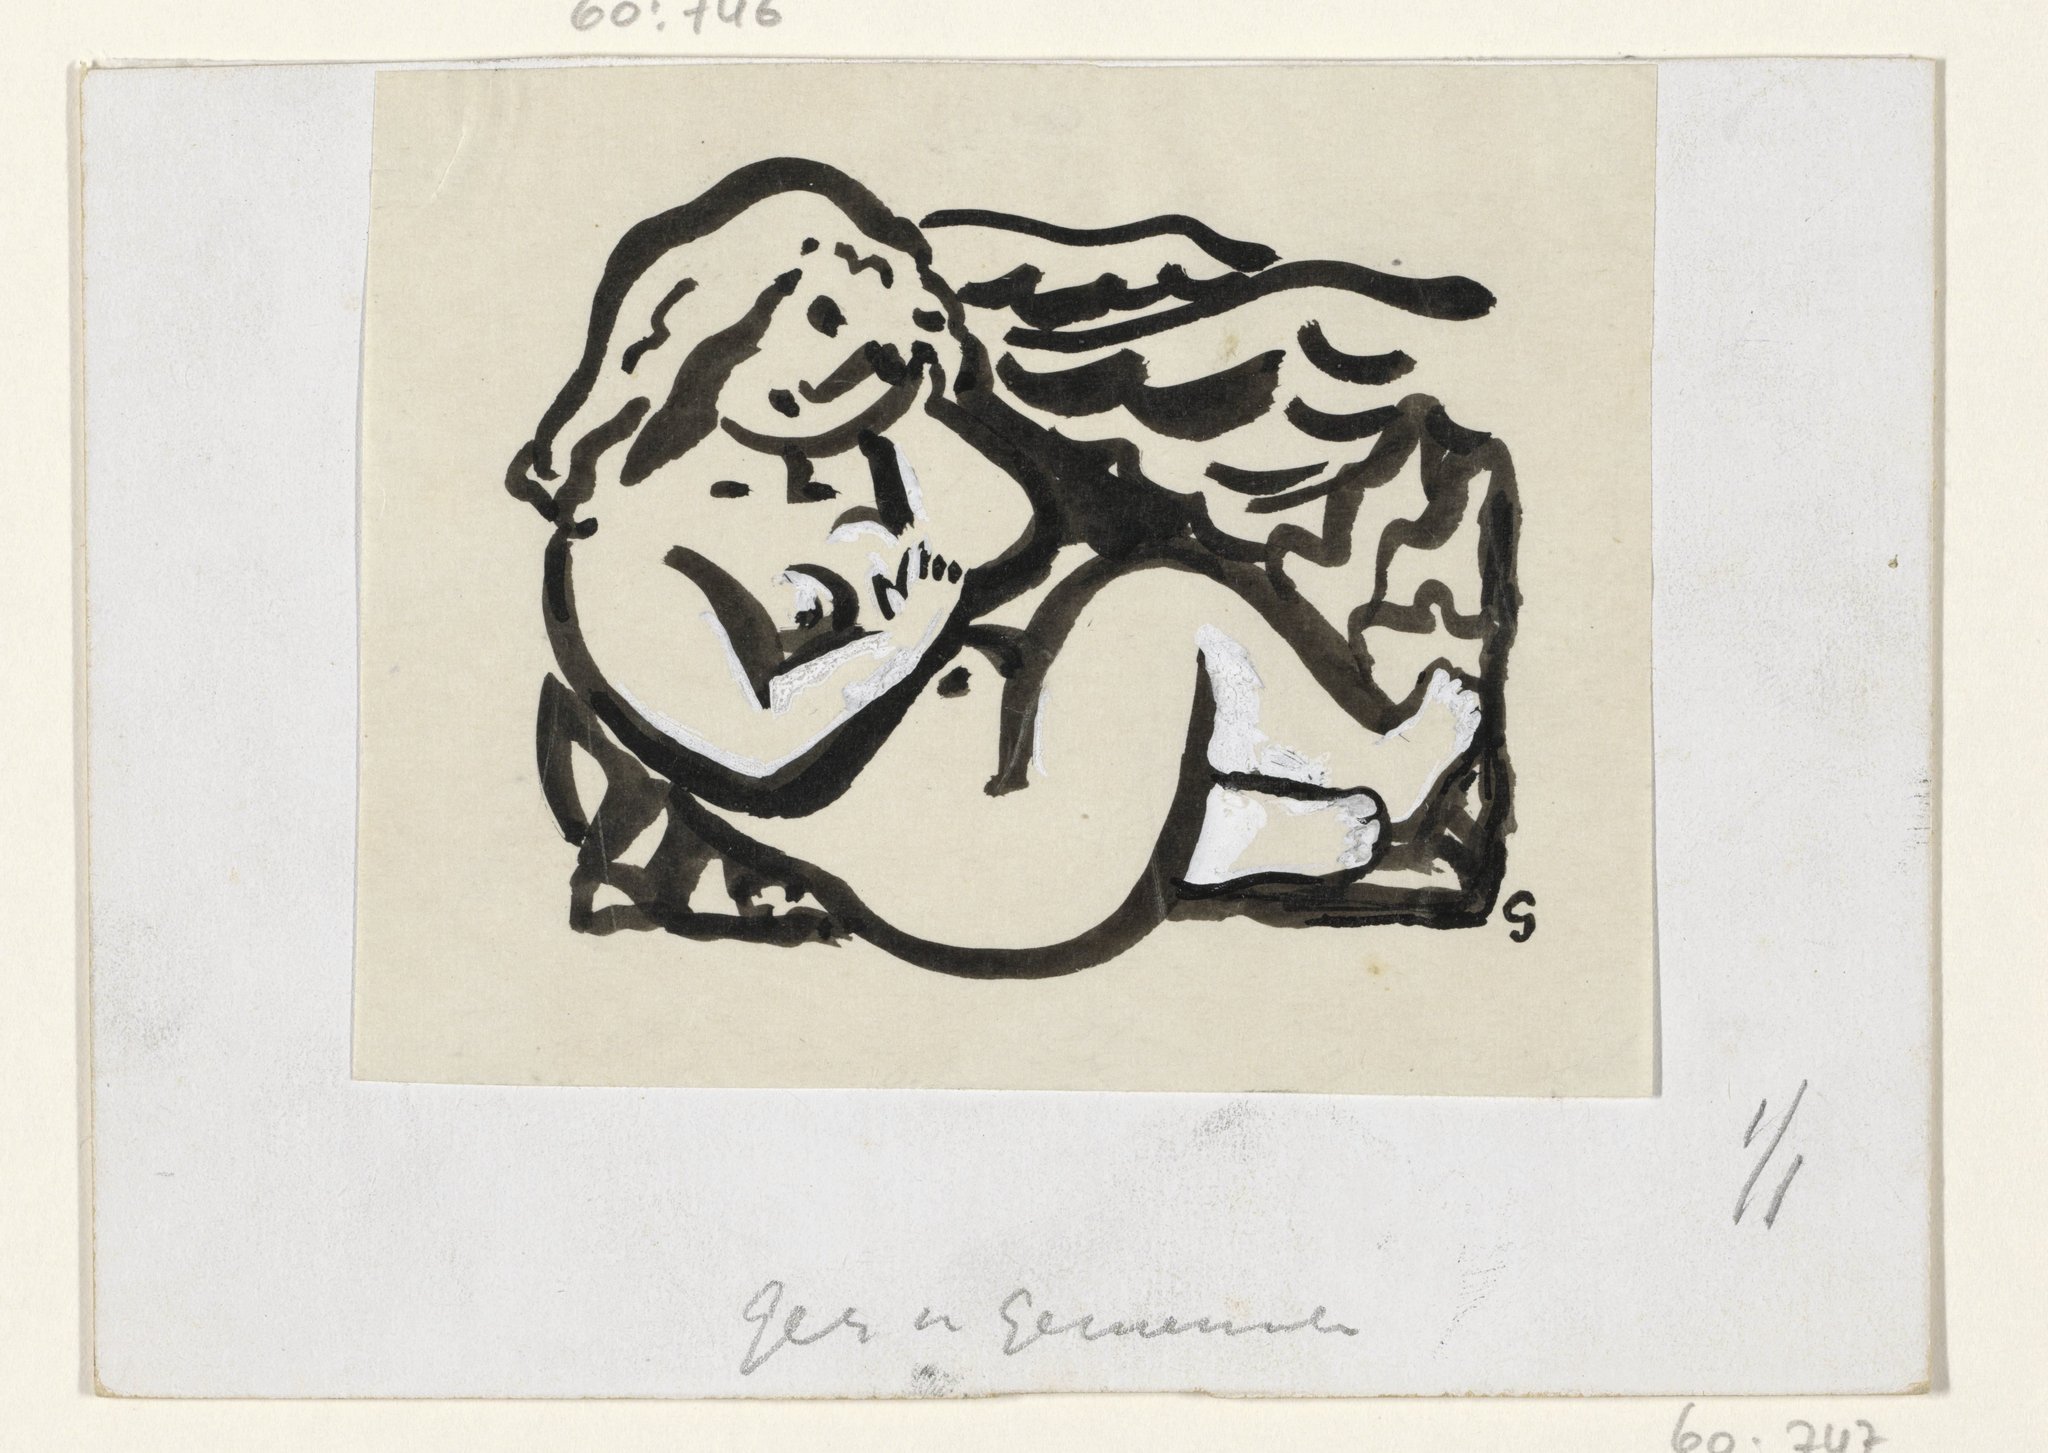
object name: design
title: Zittend vrouwelijk naakt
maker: leo gestel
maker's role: draughtsman, print maker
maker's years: 1881-1941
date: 1937-1939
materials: paint, ink, paper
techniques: brush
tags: sitting figure - aa - female human figure (+ nude human being)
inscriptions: collector's mark: Lugt 2228, :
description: Ontwerp voor een illustratie voor: De Gemeenschap, januari 1939.